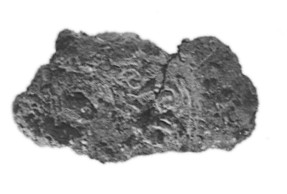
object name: sealing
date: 2030-1640 BCE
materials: clay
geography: egypt